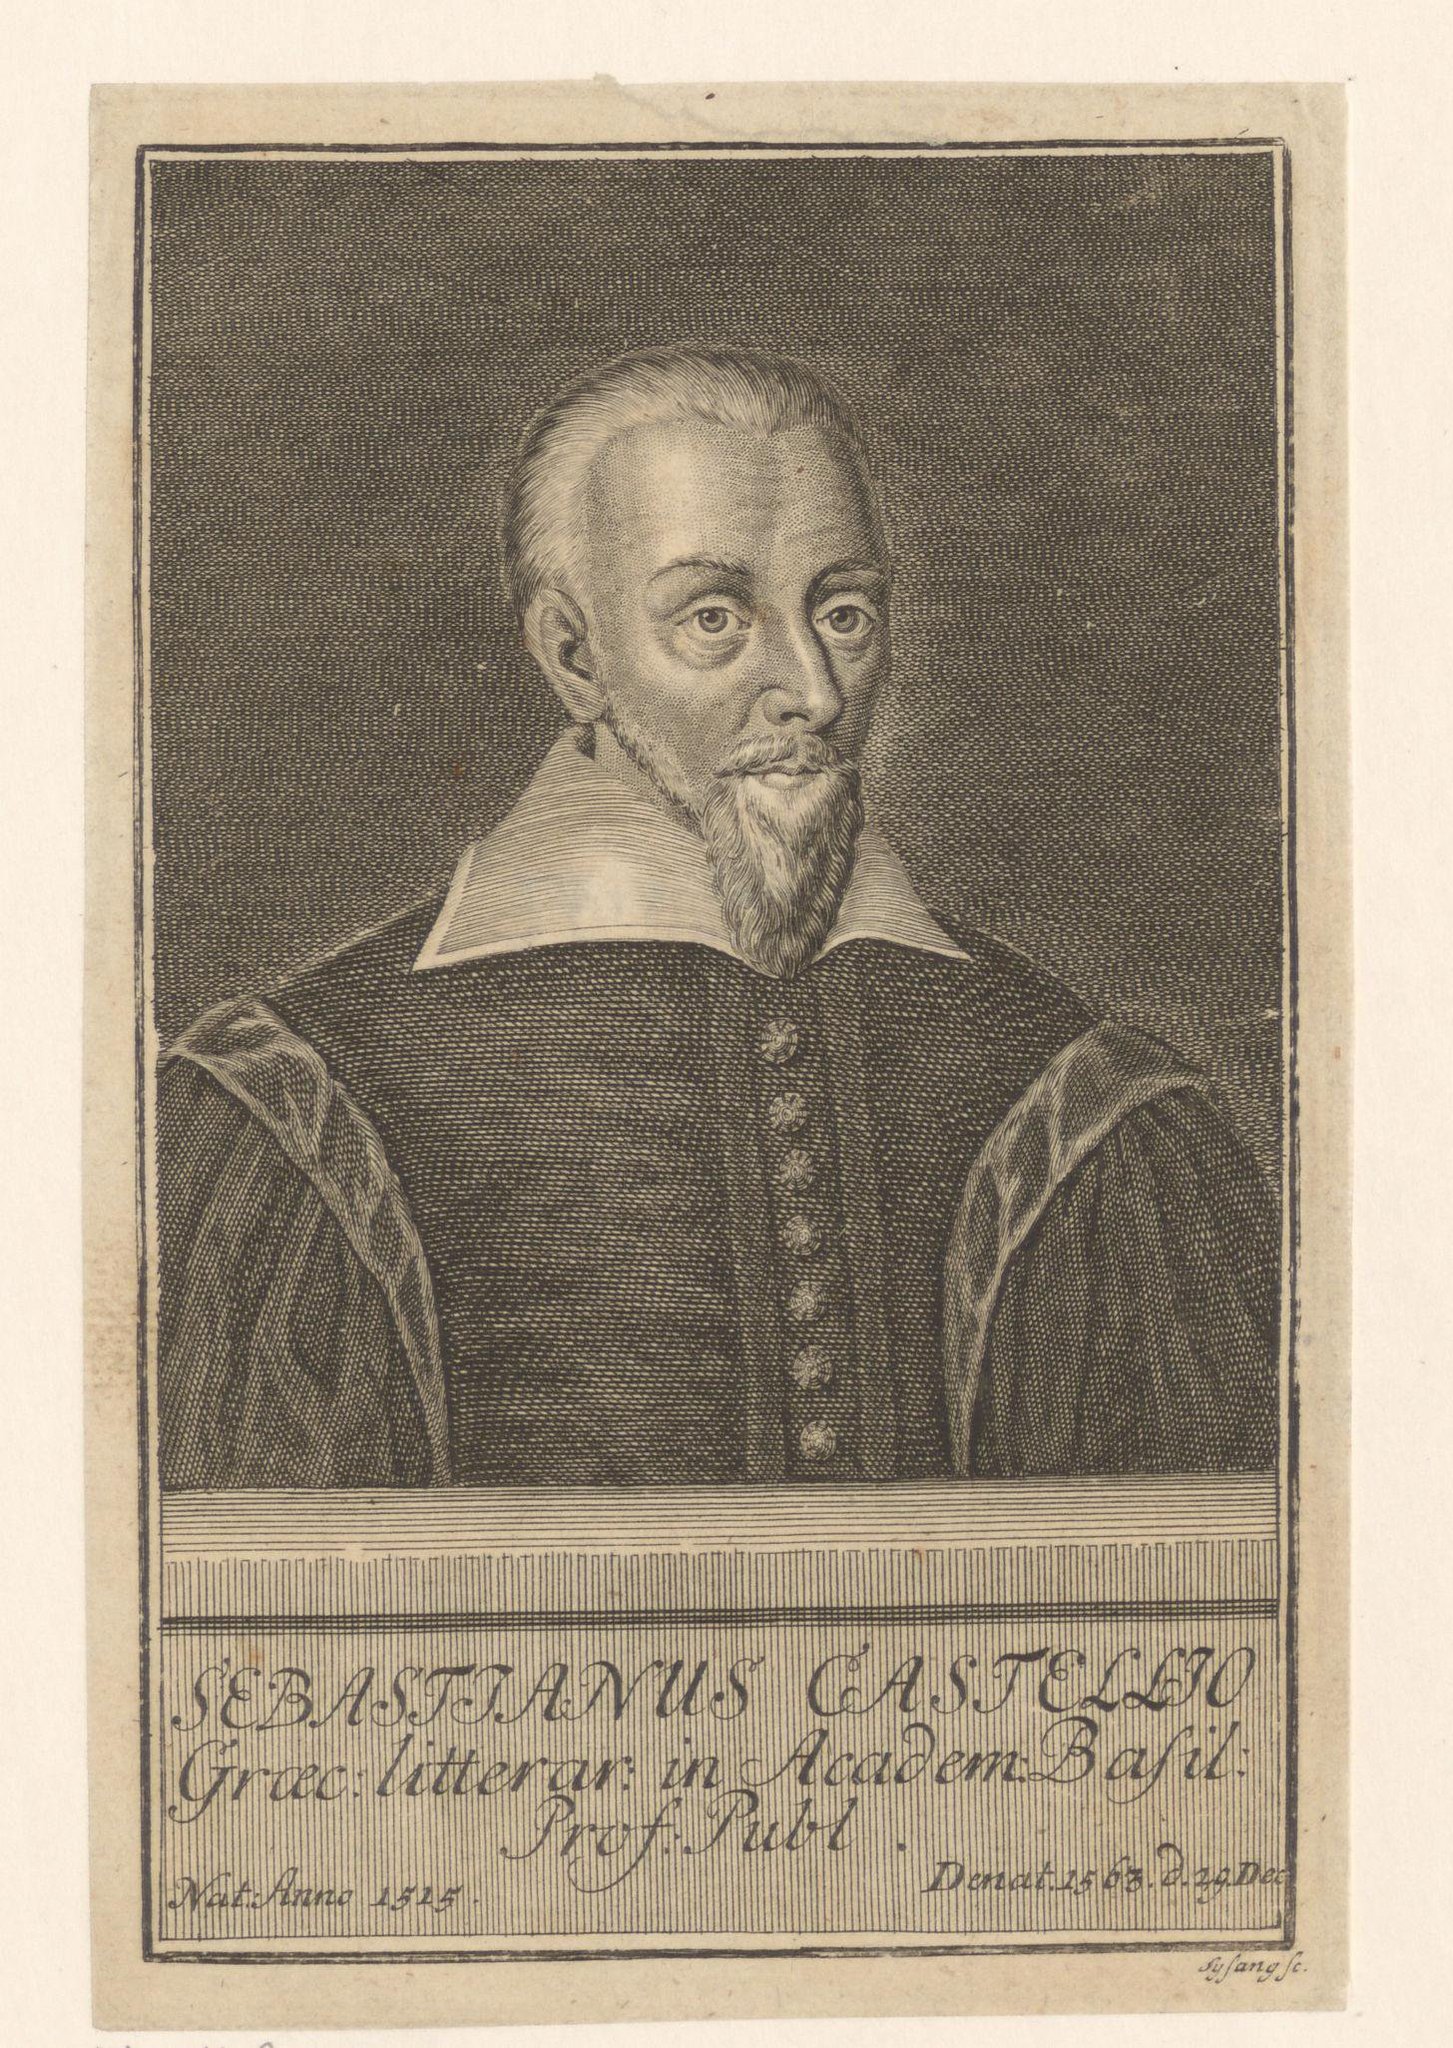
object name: print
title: Portret van Sebastian Castellio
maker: johann christoph sysang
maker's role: print maker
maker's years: 1703-1757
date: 1713-1757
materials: paper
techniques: engraving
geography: germany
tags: historical persons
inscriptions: collector's mark: Lugt 2228